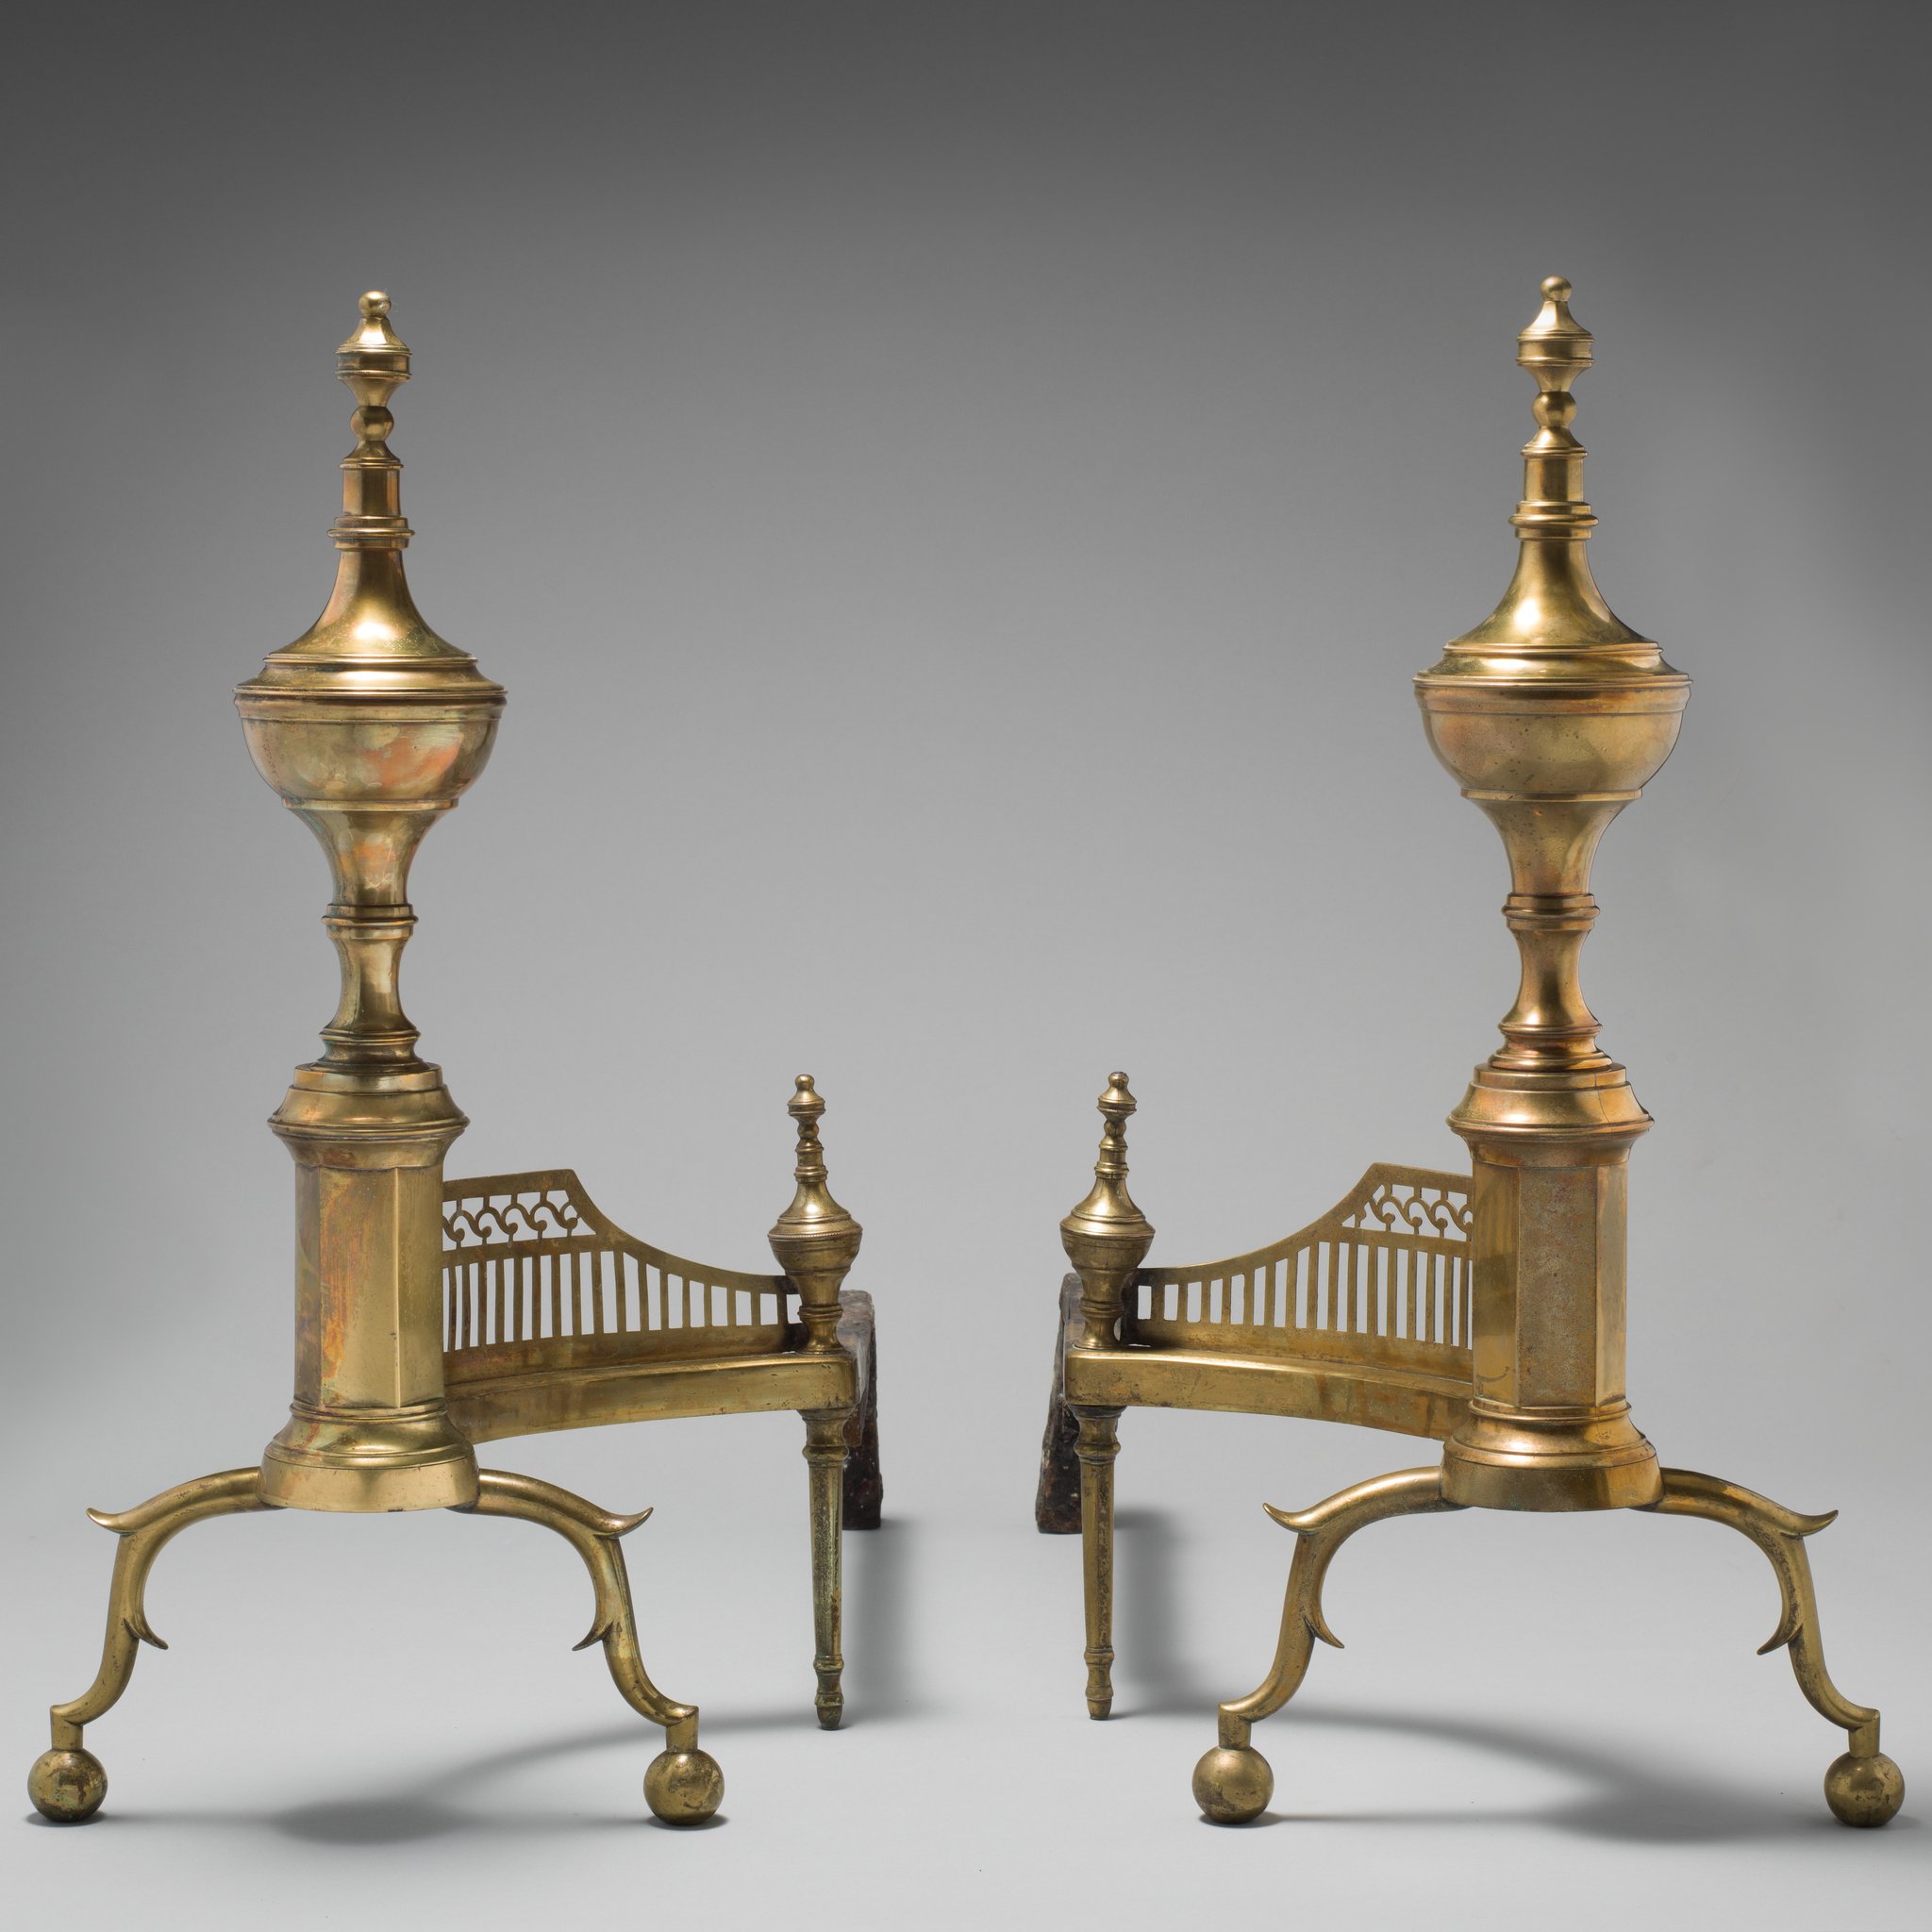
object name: andiron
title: Pair of andirons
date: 1701-1800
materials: brass